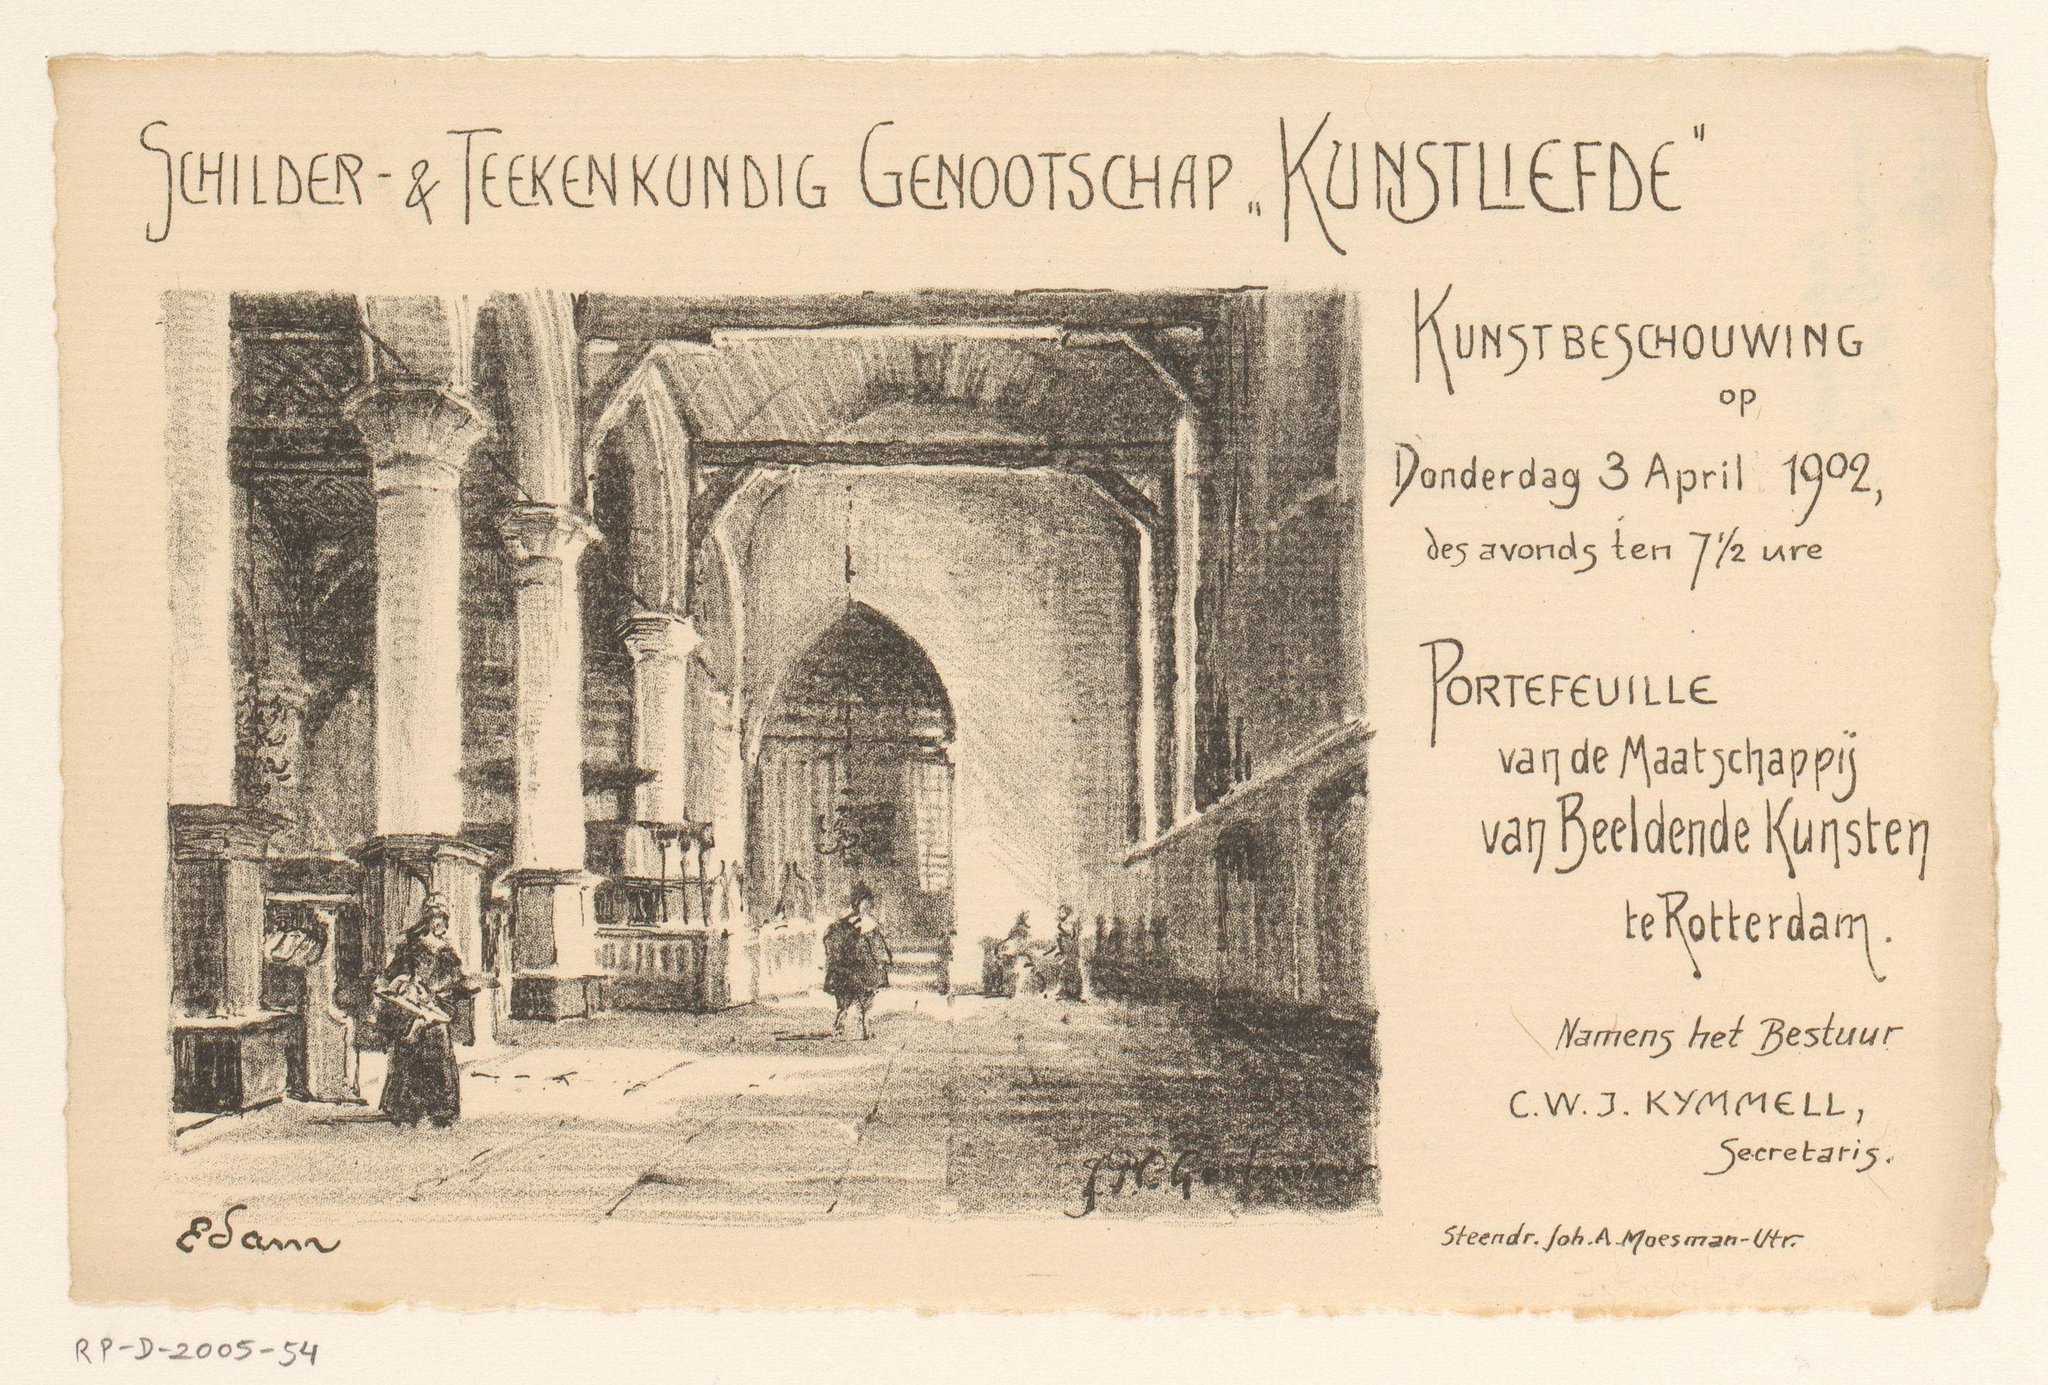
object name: print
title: Uitnodiging van Schilder- en Teekenkundig Genootschap "Kunstliefde" voor een kunstbeschouwing, 3 april 1902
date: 1902-1904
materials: paper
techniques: lithograph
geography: utrecht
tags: criticizing and discussing art, art criticism, circle, club of artists, collecting and exhibiting products of the fine arts, interior of church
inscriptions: collector's mark: Lugt 2228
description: Kerkinterieur. Uitnodiging van Schilder- en Teekenkundig Genootschap "Kunstliefde" voor een kunstbeschouwing op 3 april 1902 van de portefeuille van de Maatschappij van Beeldende Kunsten te Rotterdam.